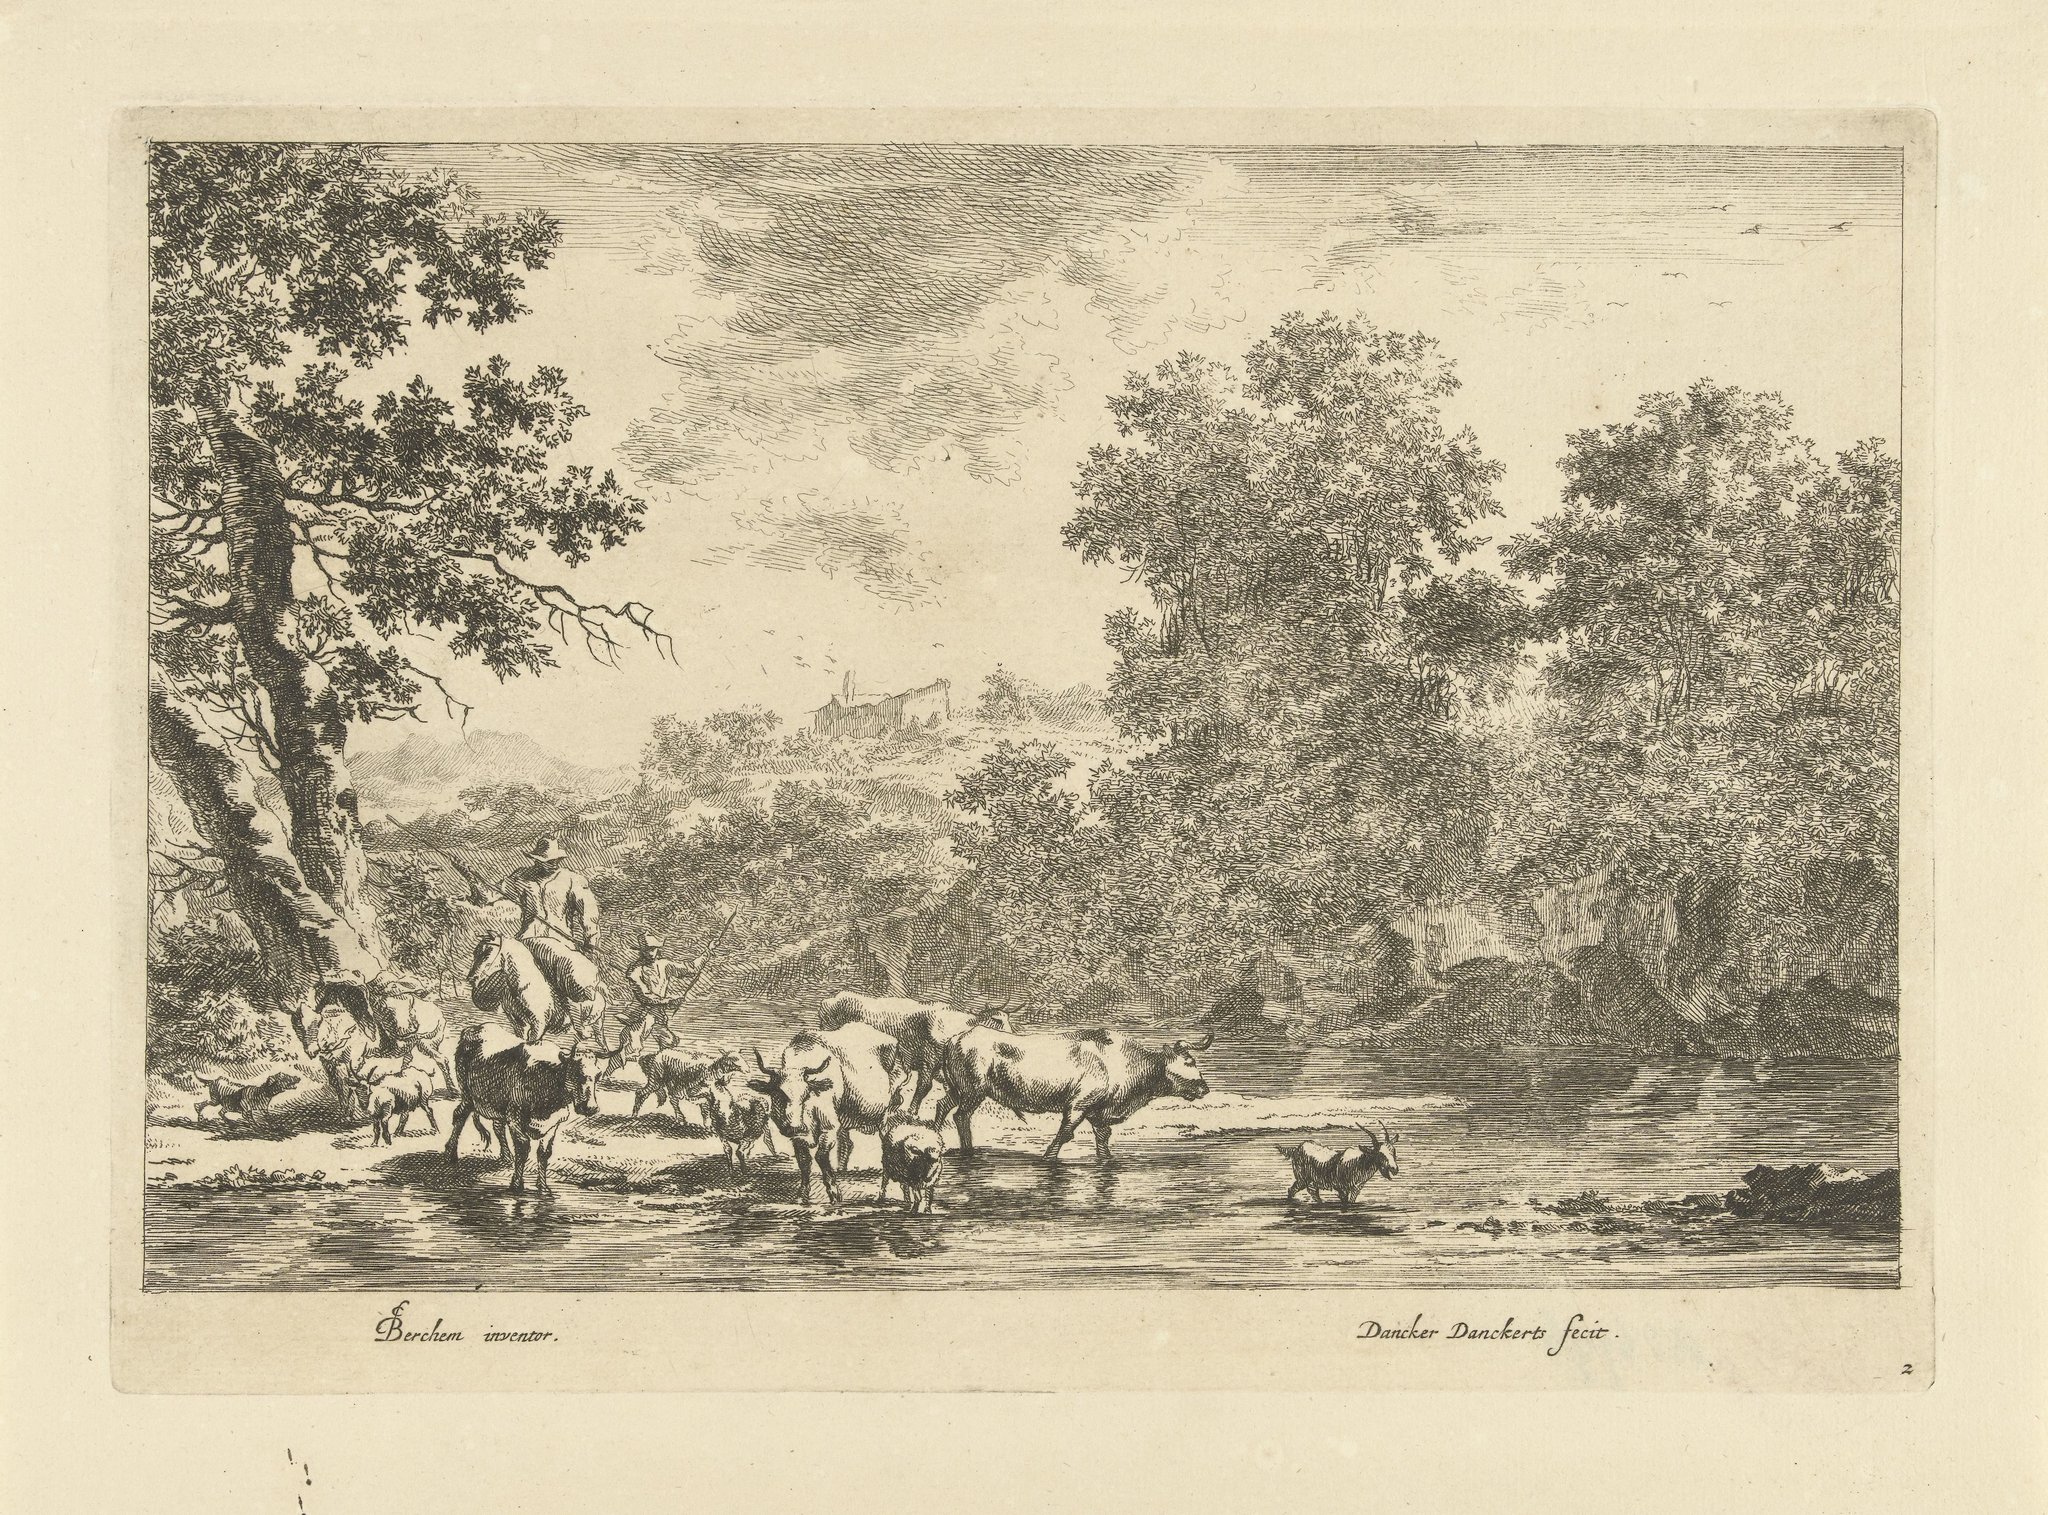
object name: print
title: Italiaans landschap met herder te paard en vee bij rivier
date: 1643-1666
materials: paper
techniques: etching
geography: amsterdam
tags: herding, herdsman, herdswoman, shepherd, shepherdess, cowherd, etc., rocks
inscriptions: collector's mark: Lugt 240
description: Prent naar ontwerp van Nicolaes Pietersz. Berchem.